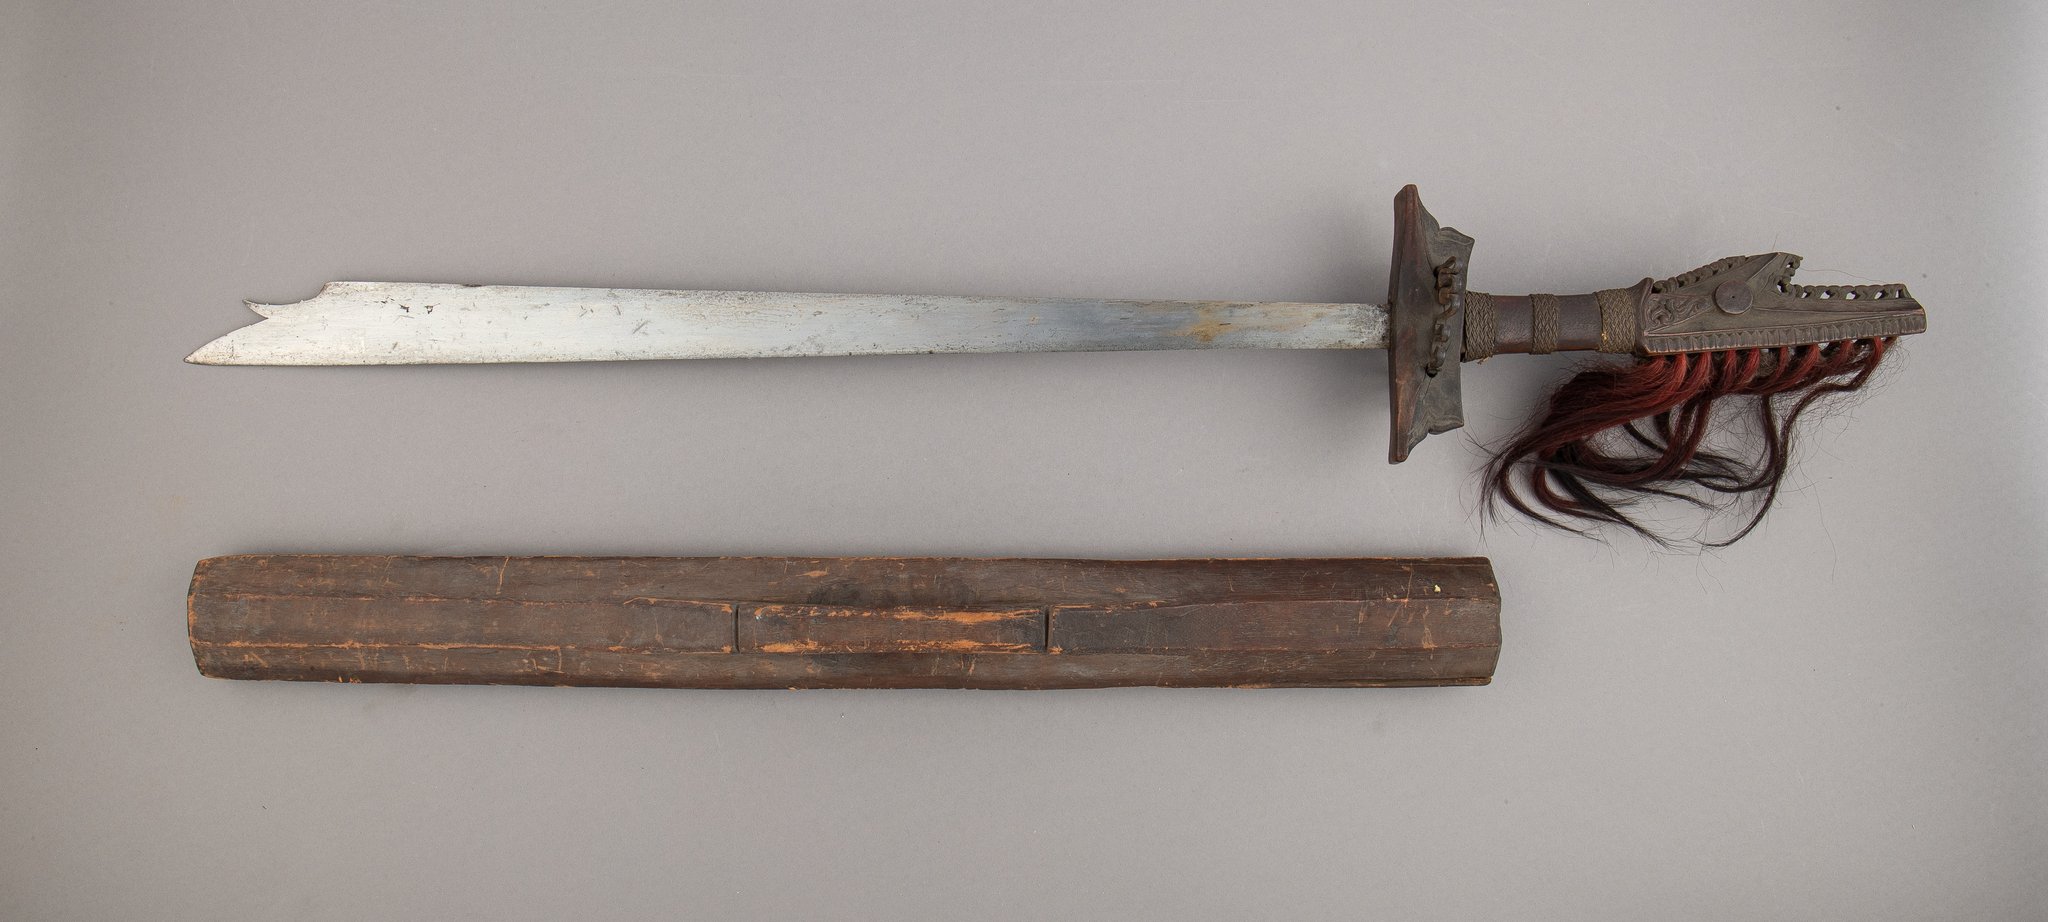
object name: sword kampilan with scabbard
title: Sword (Kampilan) with Scabbard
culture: philippine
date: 1701-1900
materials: hair, steel, wood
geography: philippines